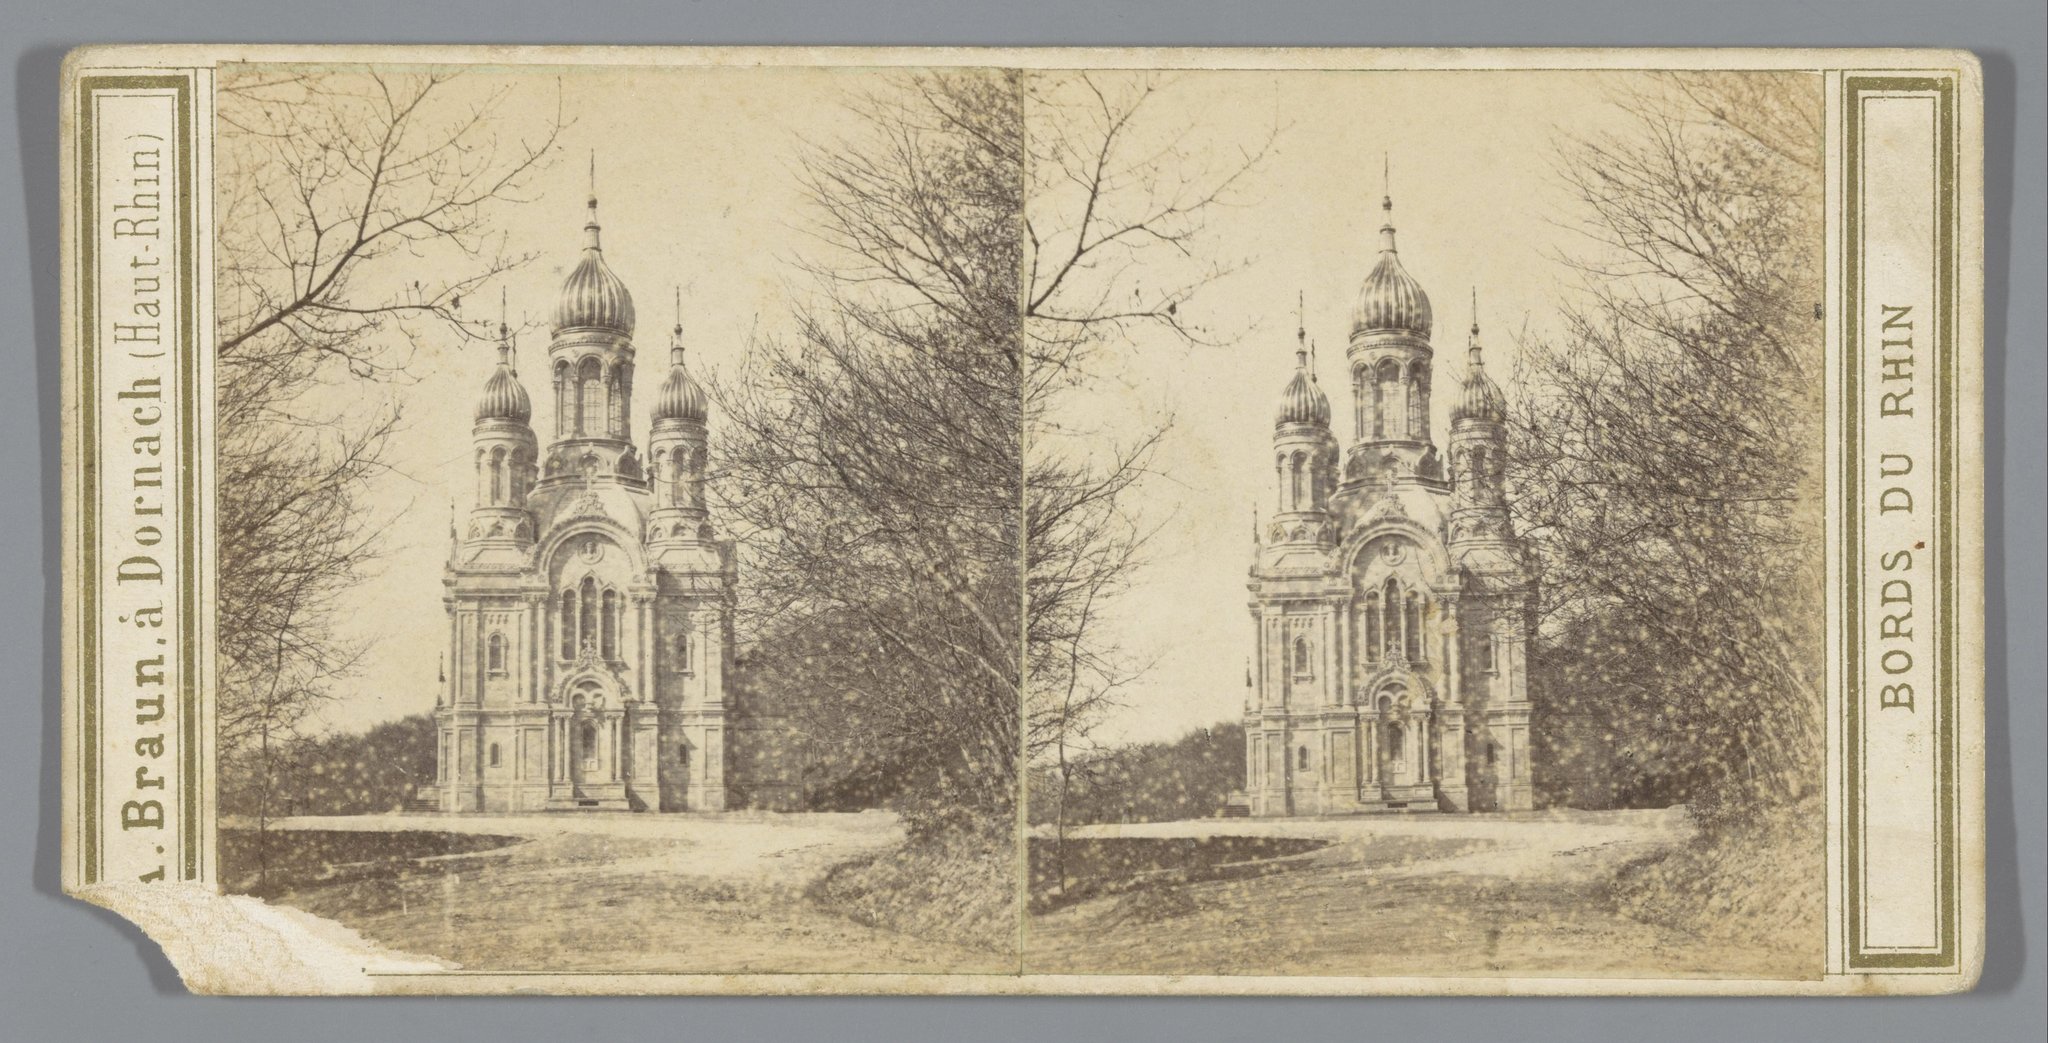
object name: stereograph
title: Bords du Rhin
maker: Anonymous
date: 1860-1866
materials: cardboard, paper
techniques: albumen print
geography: dornach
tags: russian orthodox church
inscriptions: number: ‘No 2542.’